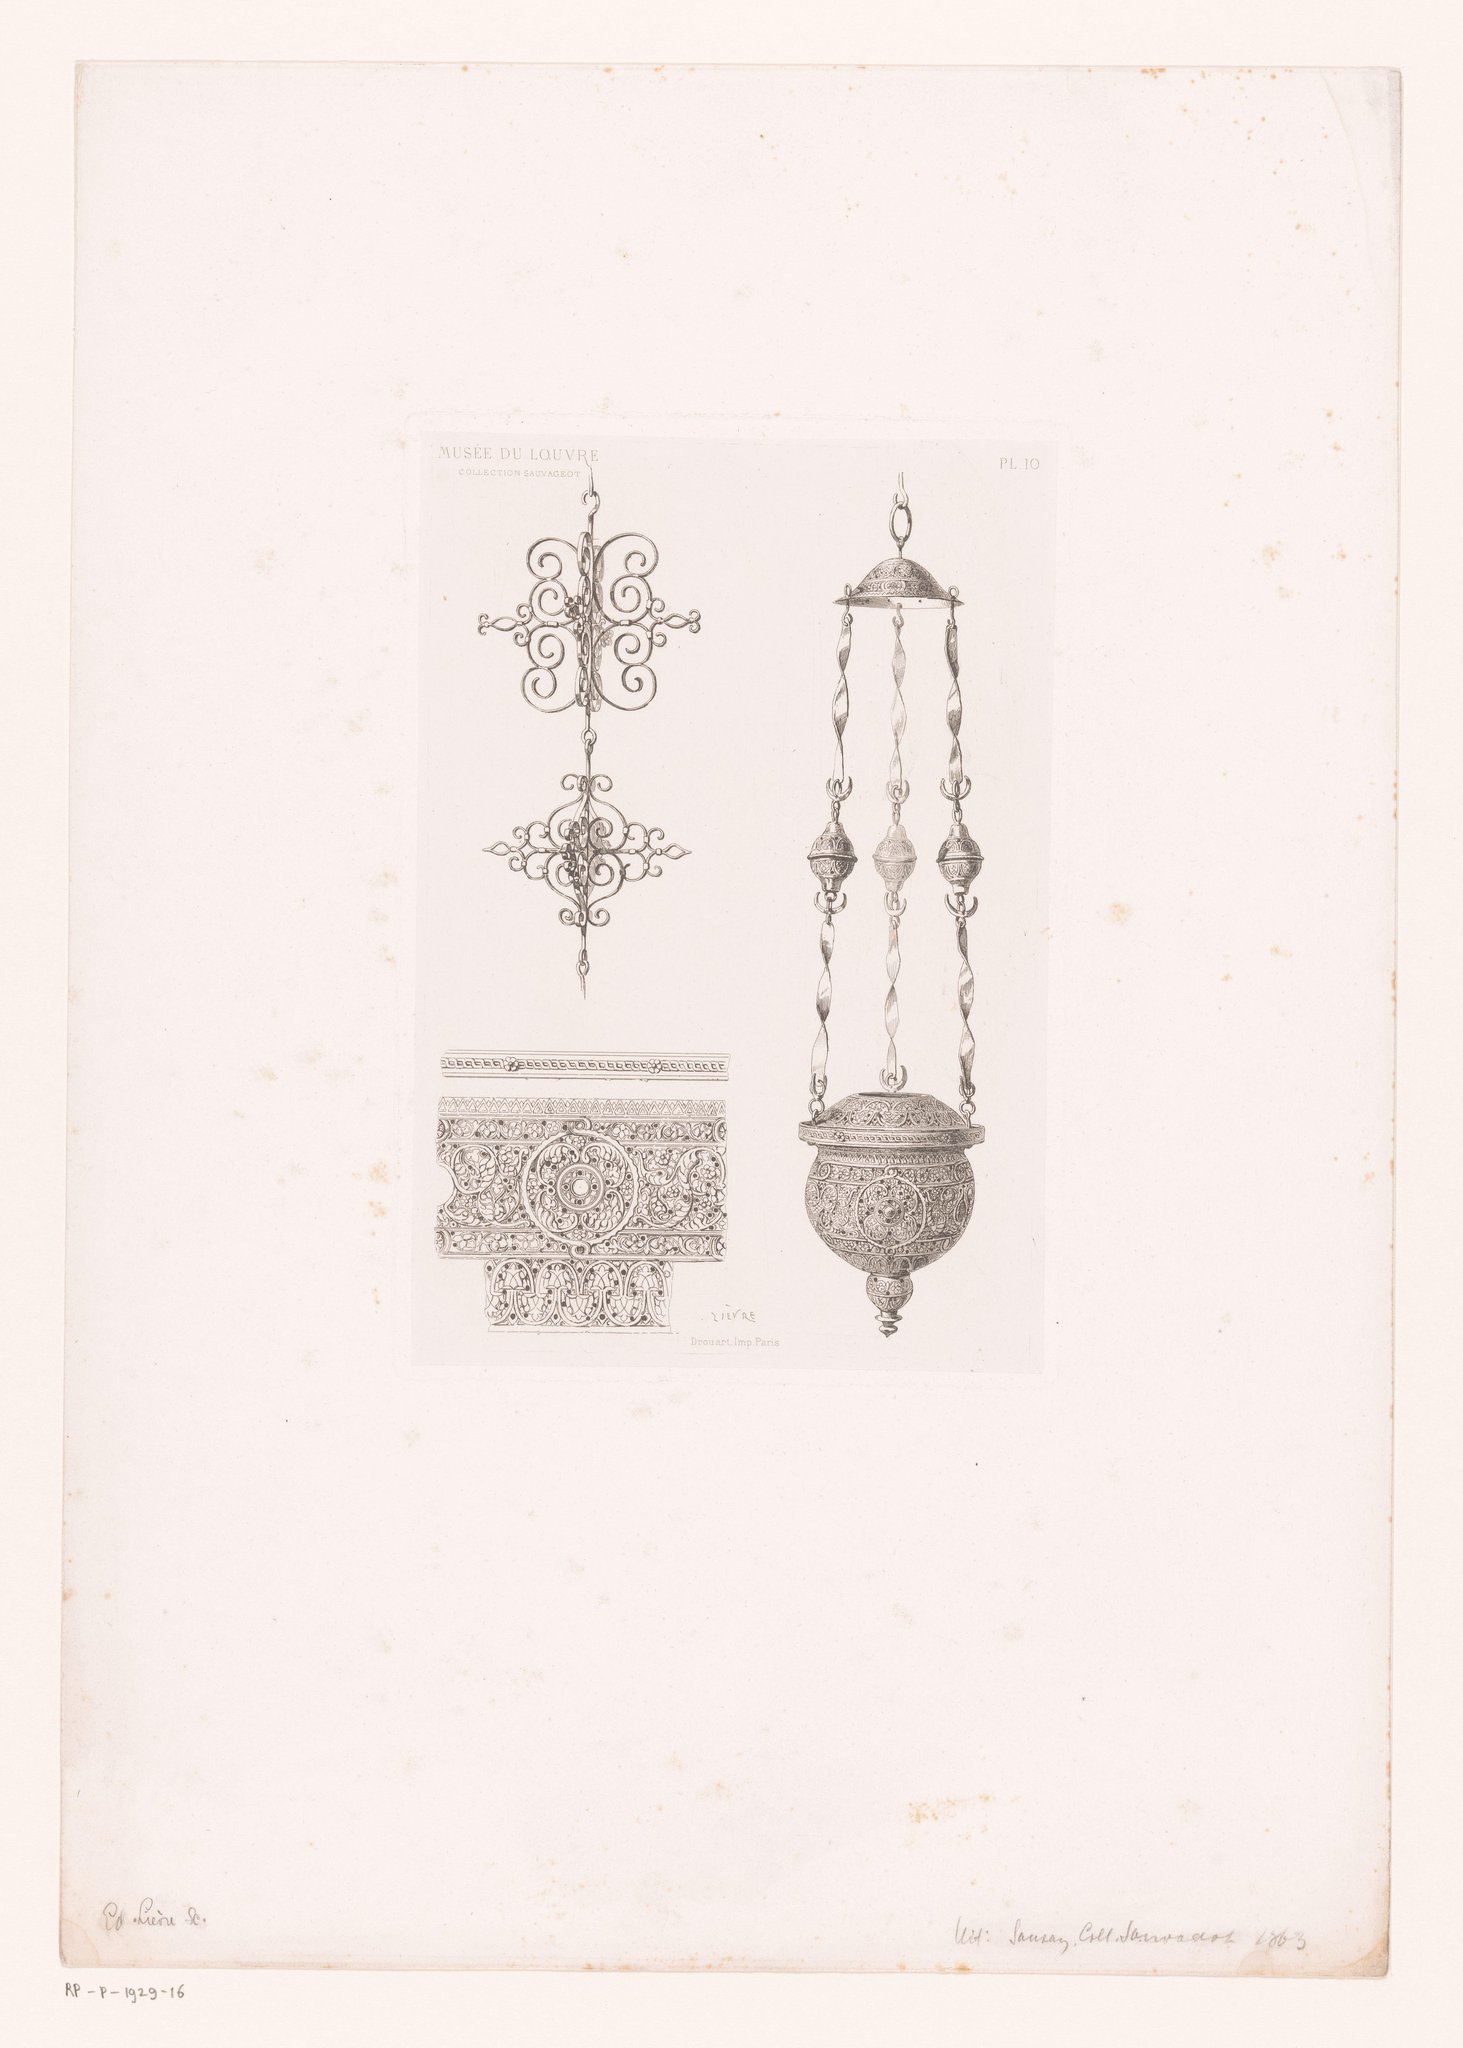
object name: print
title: Wierookvat en twee ornamenten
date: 1863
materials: paper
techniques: etching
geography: paris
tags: (liturgical) equipment of church, incense-burner ~ scents, perfumes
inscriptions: collector's mark: Lugt 2228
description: Prent uit: Sauzay, Alexandre. Musée Impérial Du Louvre - Collection Sauvageot Dessinée Et Gravée A L'Eau-Forte Par Édouard Lièvre Accompagnée D'Un Texte Historique Et Descriptif Par A. Sauzay. Parijs: Noblet et Baudry, 1863. In deze publicatie worden metalen objecten beschreven uit de Gotiek en de Renaissance uit de collectie van Charles Sauvageot, in 1856 geschonken aan het Musée du Louvre.